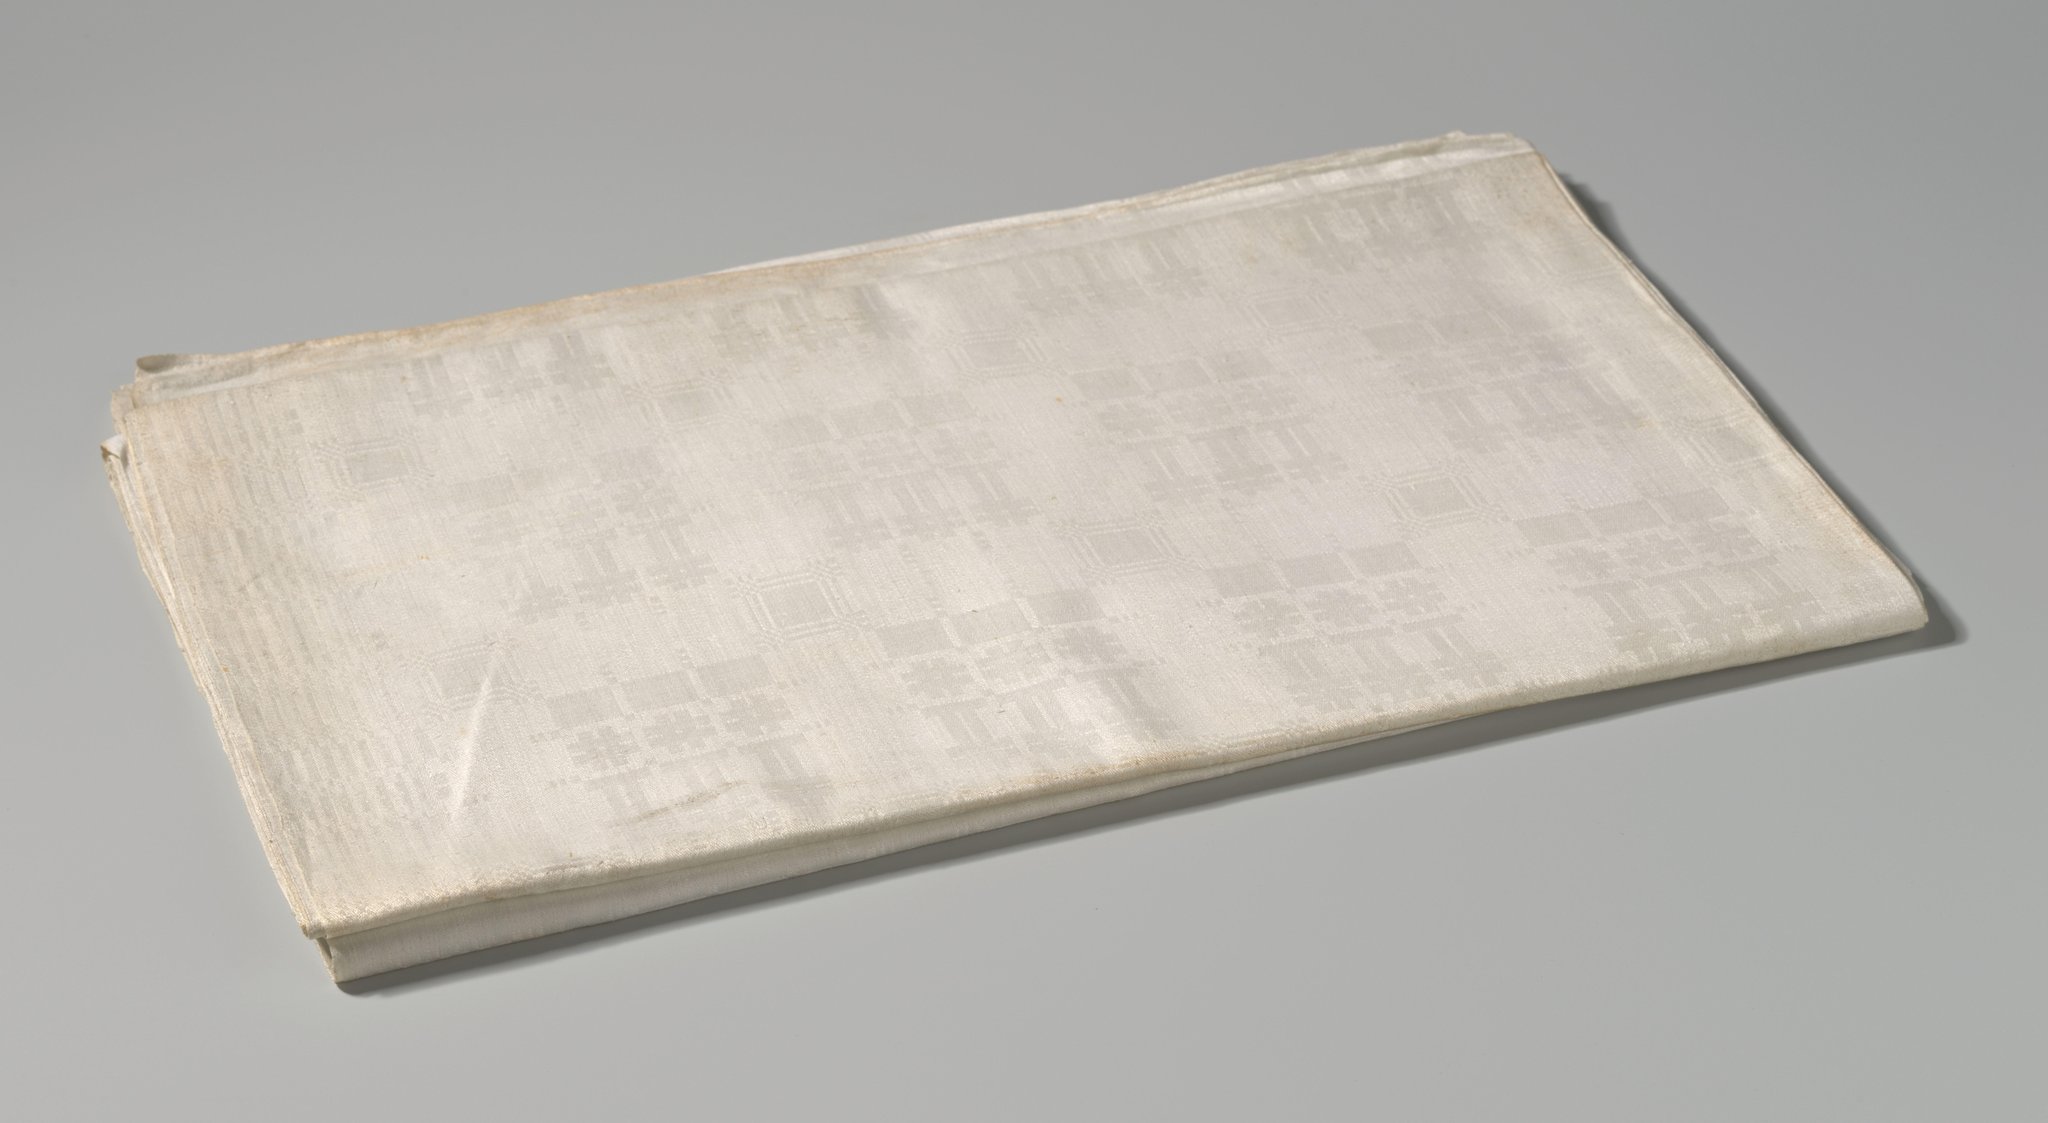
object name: tablecloth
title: Pellen. Merk: kroon ARVG2.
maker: Anonymous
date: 1725-1769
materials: linen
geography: northern netherlands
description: Tafellaken van wit linnen met pellen patroon, merk kroon ARVG 2